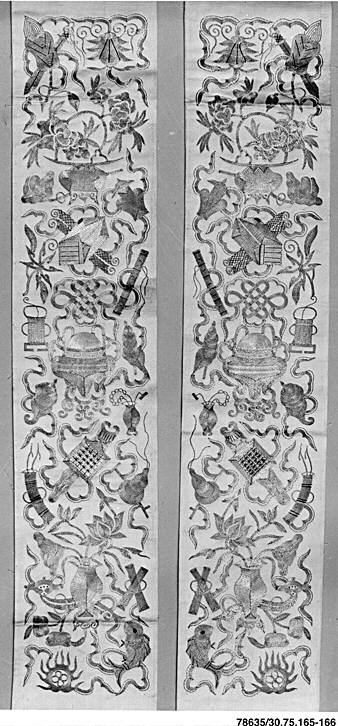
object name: sleeve band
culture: chinese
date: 1801-1900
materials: metal thread, silk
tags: flowers